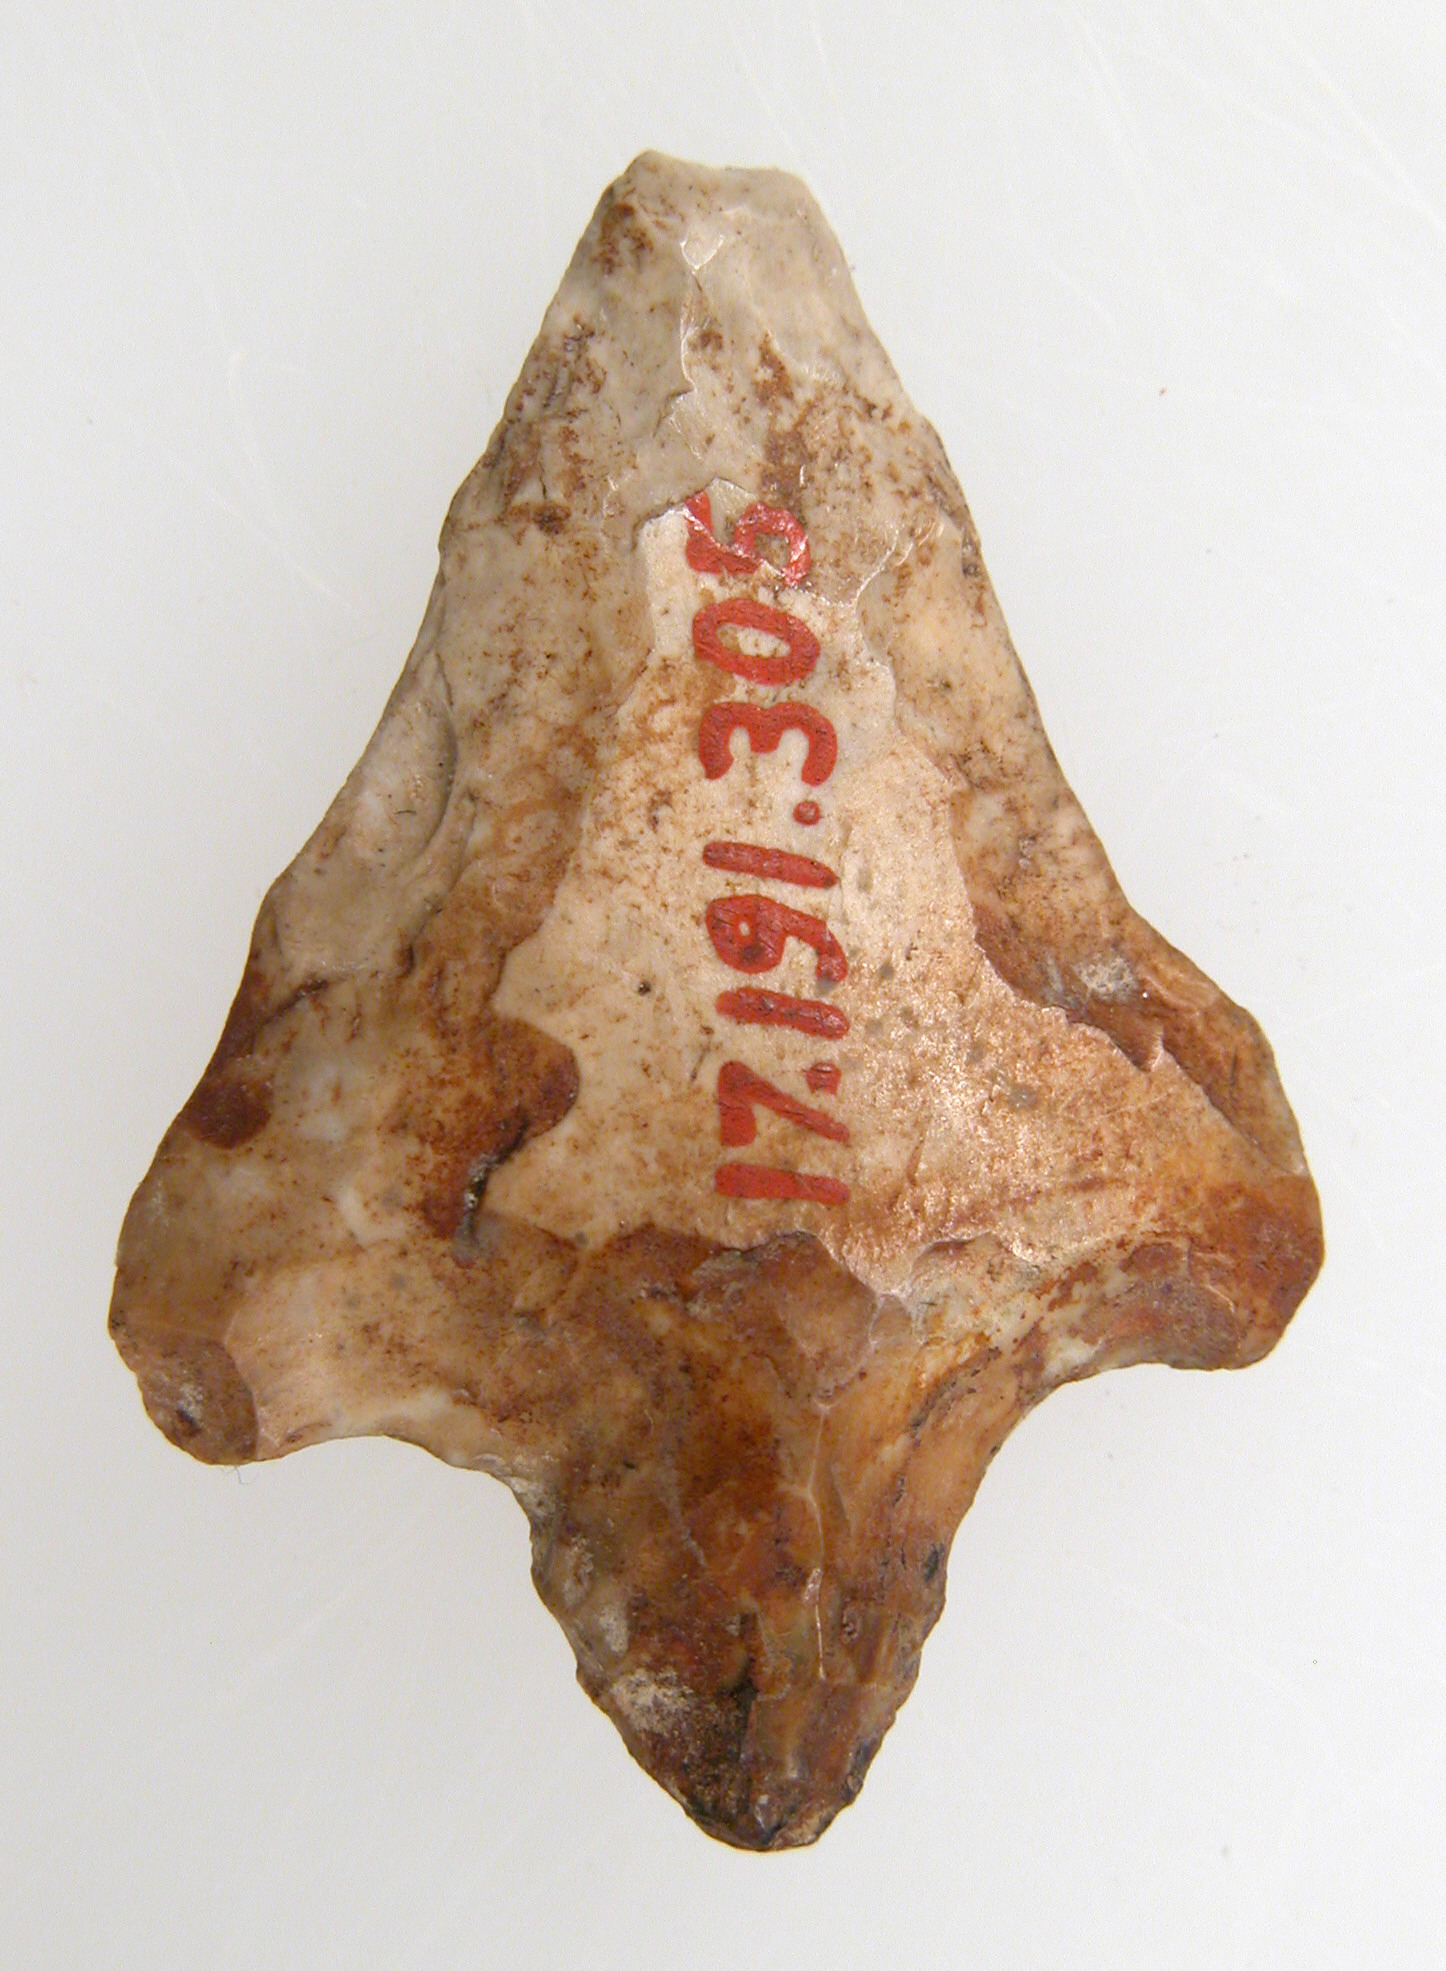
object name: arrowhead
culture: frankish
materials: stone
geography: northern france